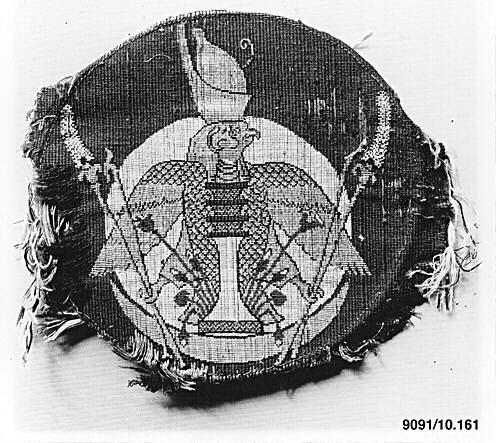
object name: medallion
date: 1800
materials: silk, wool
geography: egypt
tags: medallions,insignia